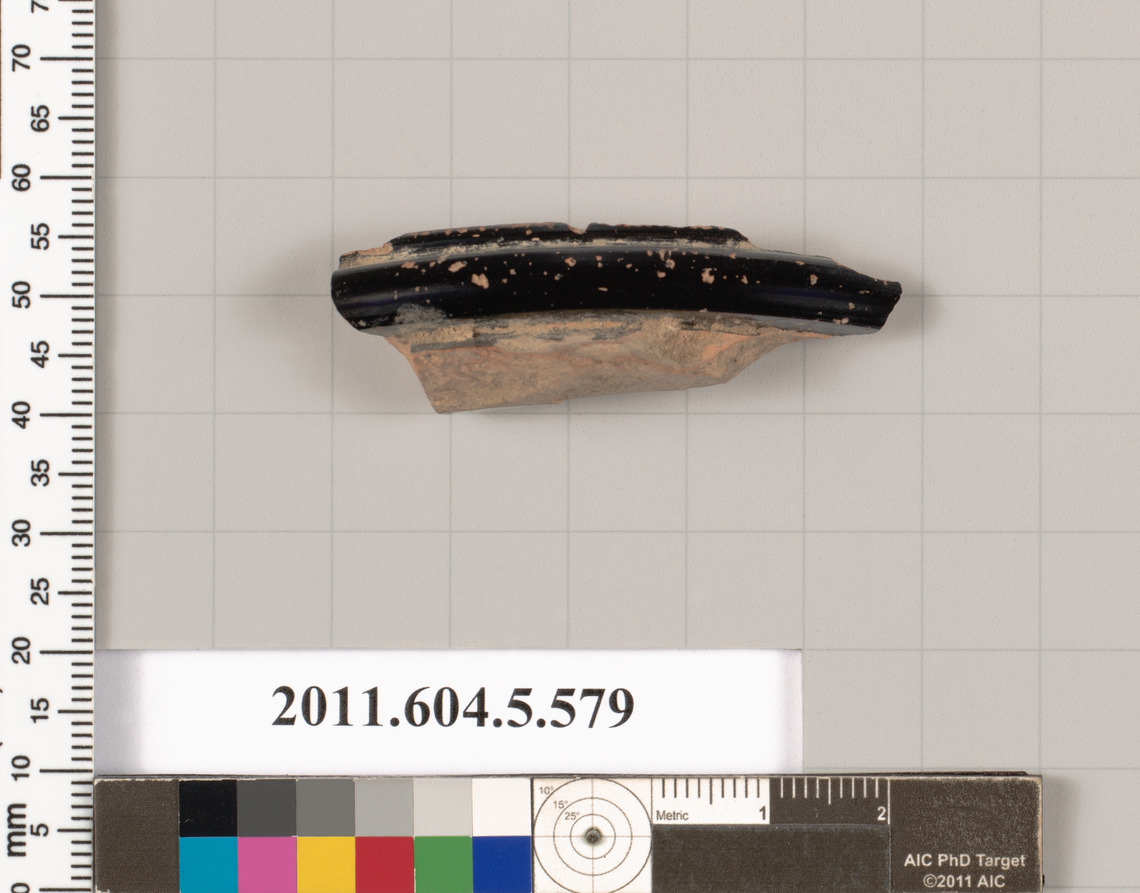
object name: stemless kylix fragment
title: Terracotta fragment of a stemless kylix (drinking cup)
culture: greek, attic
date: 600-401 BCE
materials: terracotta